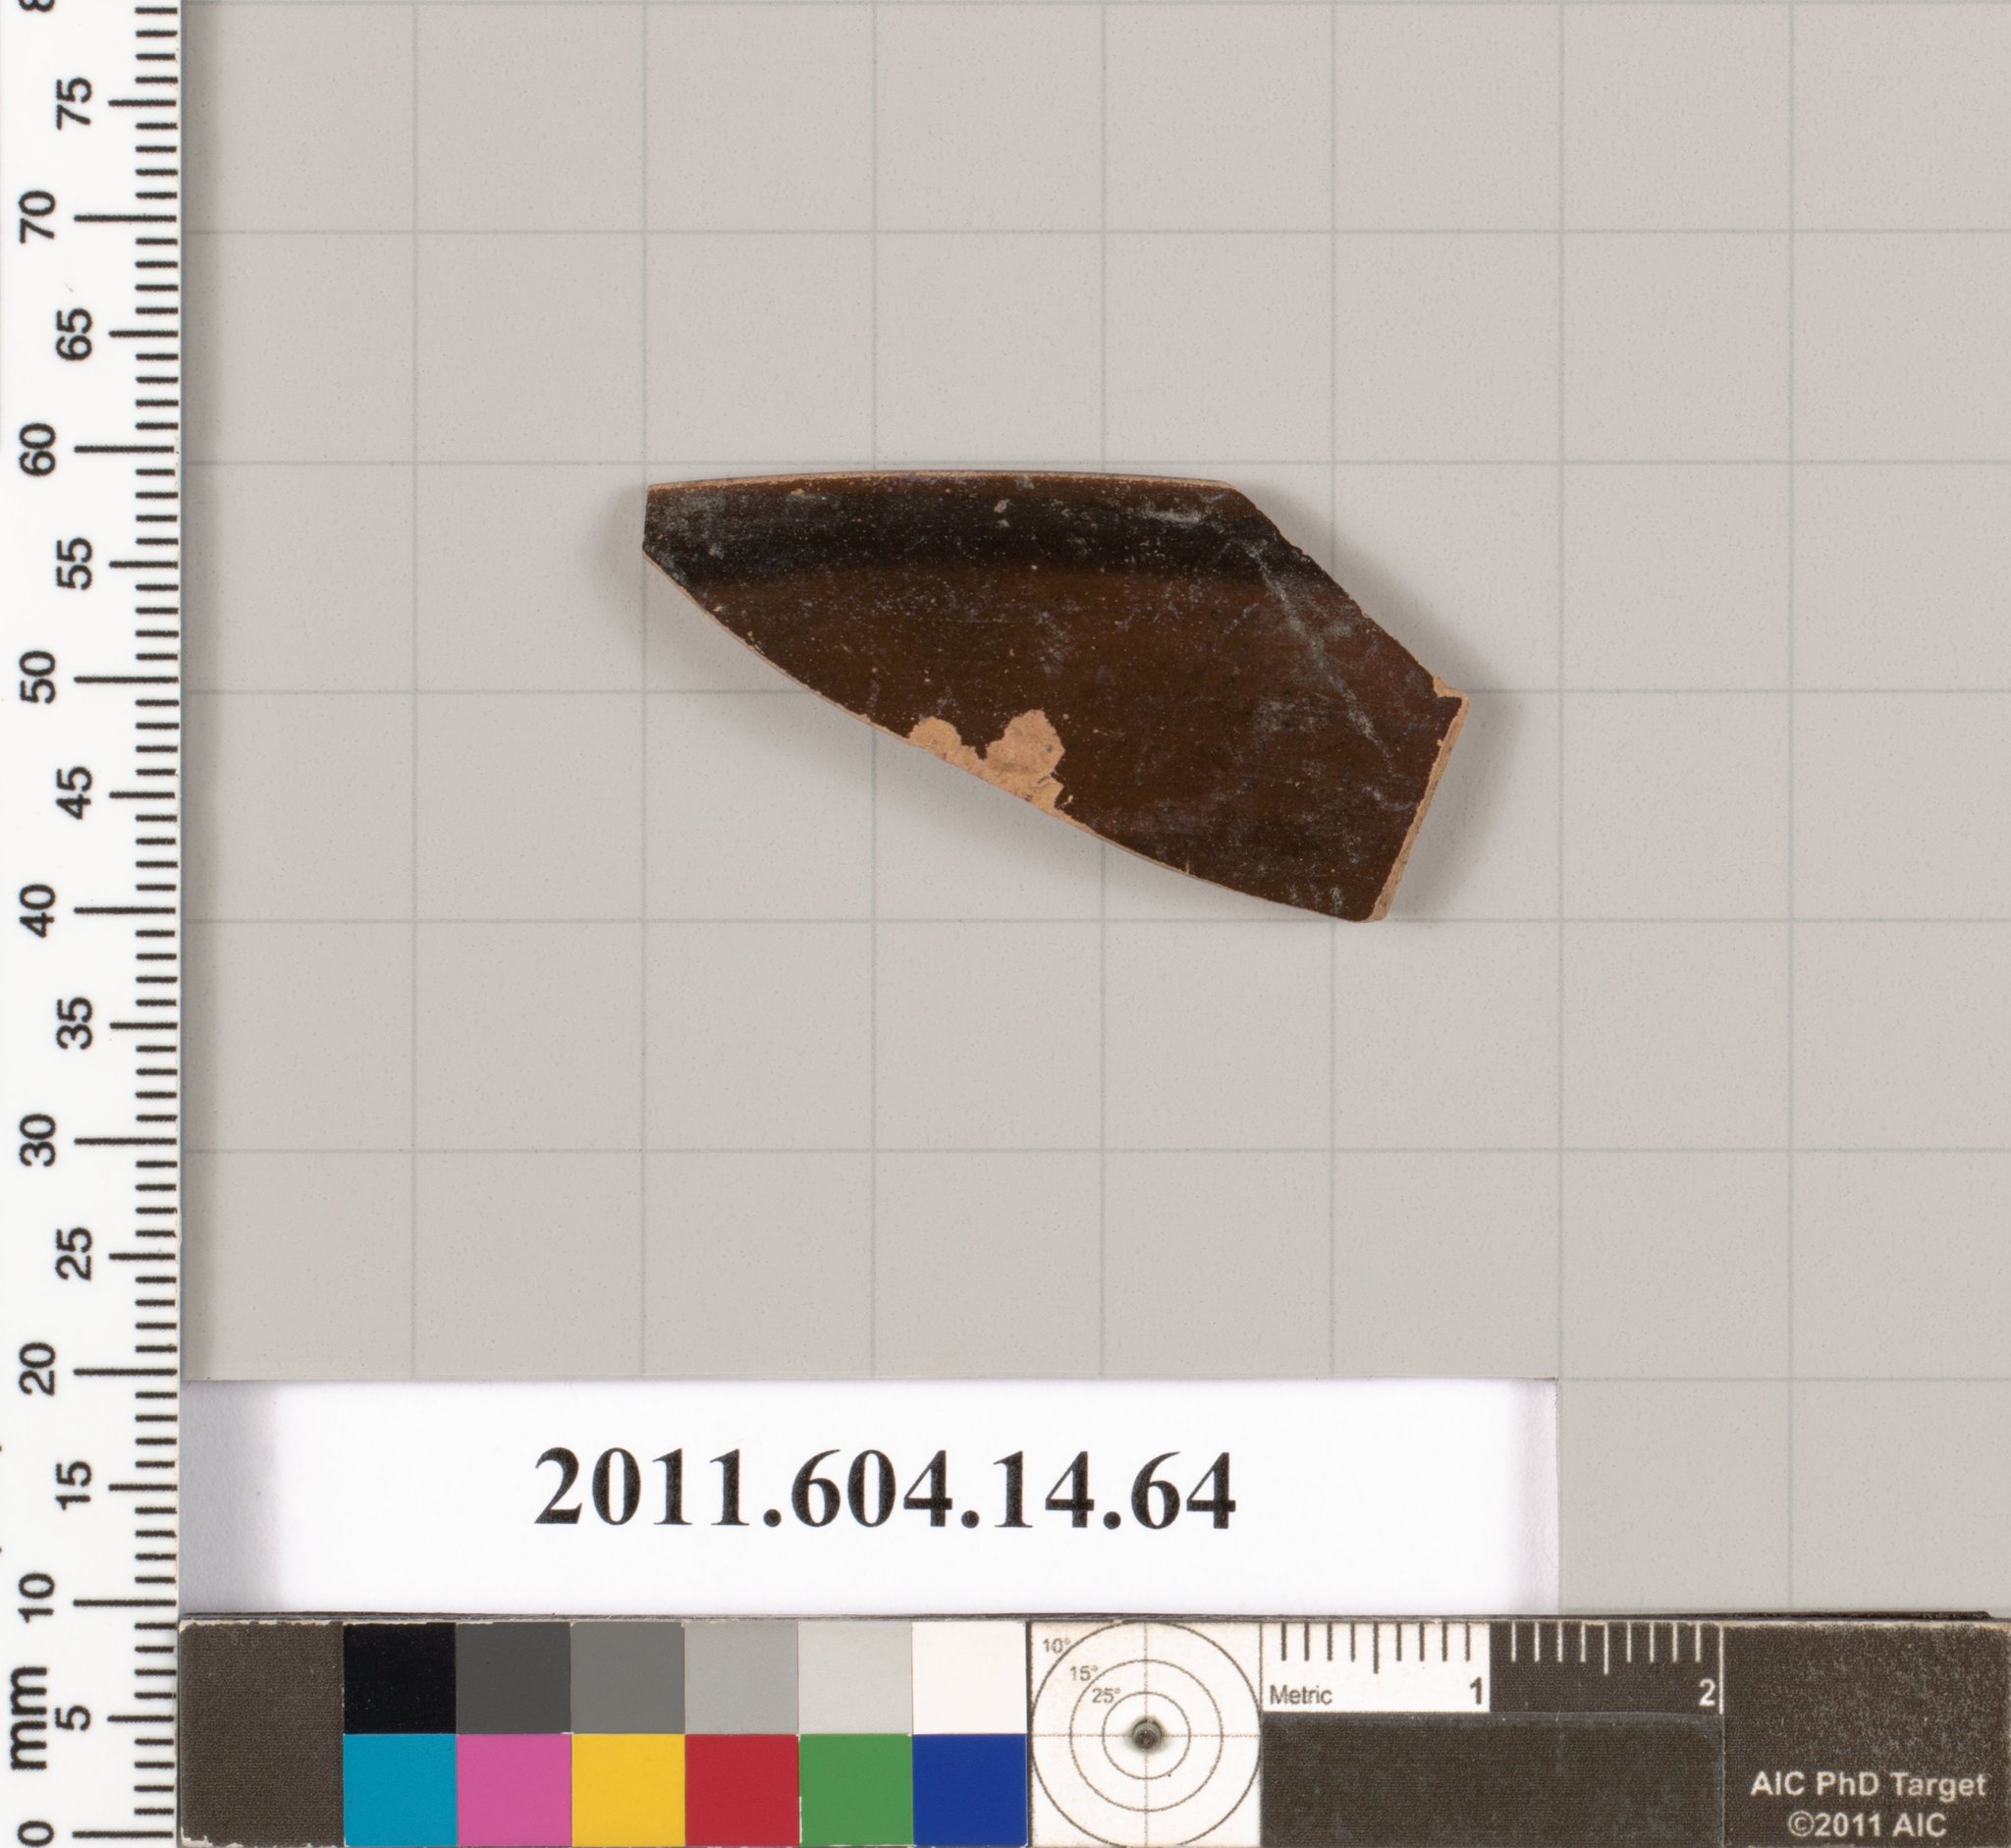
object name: kylix fragment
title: Terracotta rim fragment of a kylix (drinking cup)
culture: unknown fabric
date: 600-401 BCE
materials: terracotta